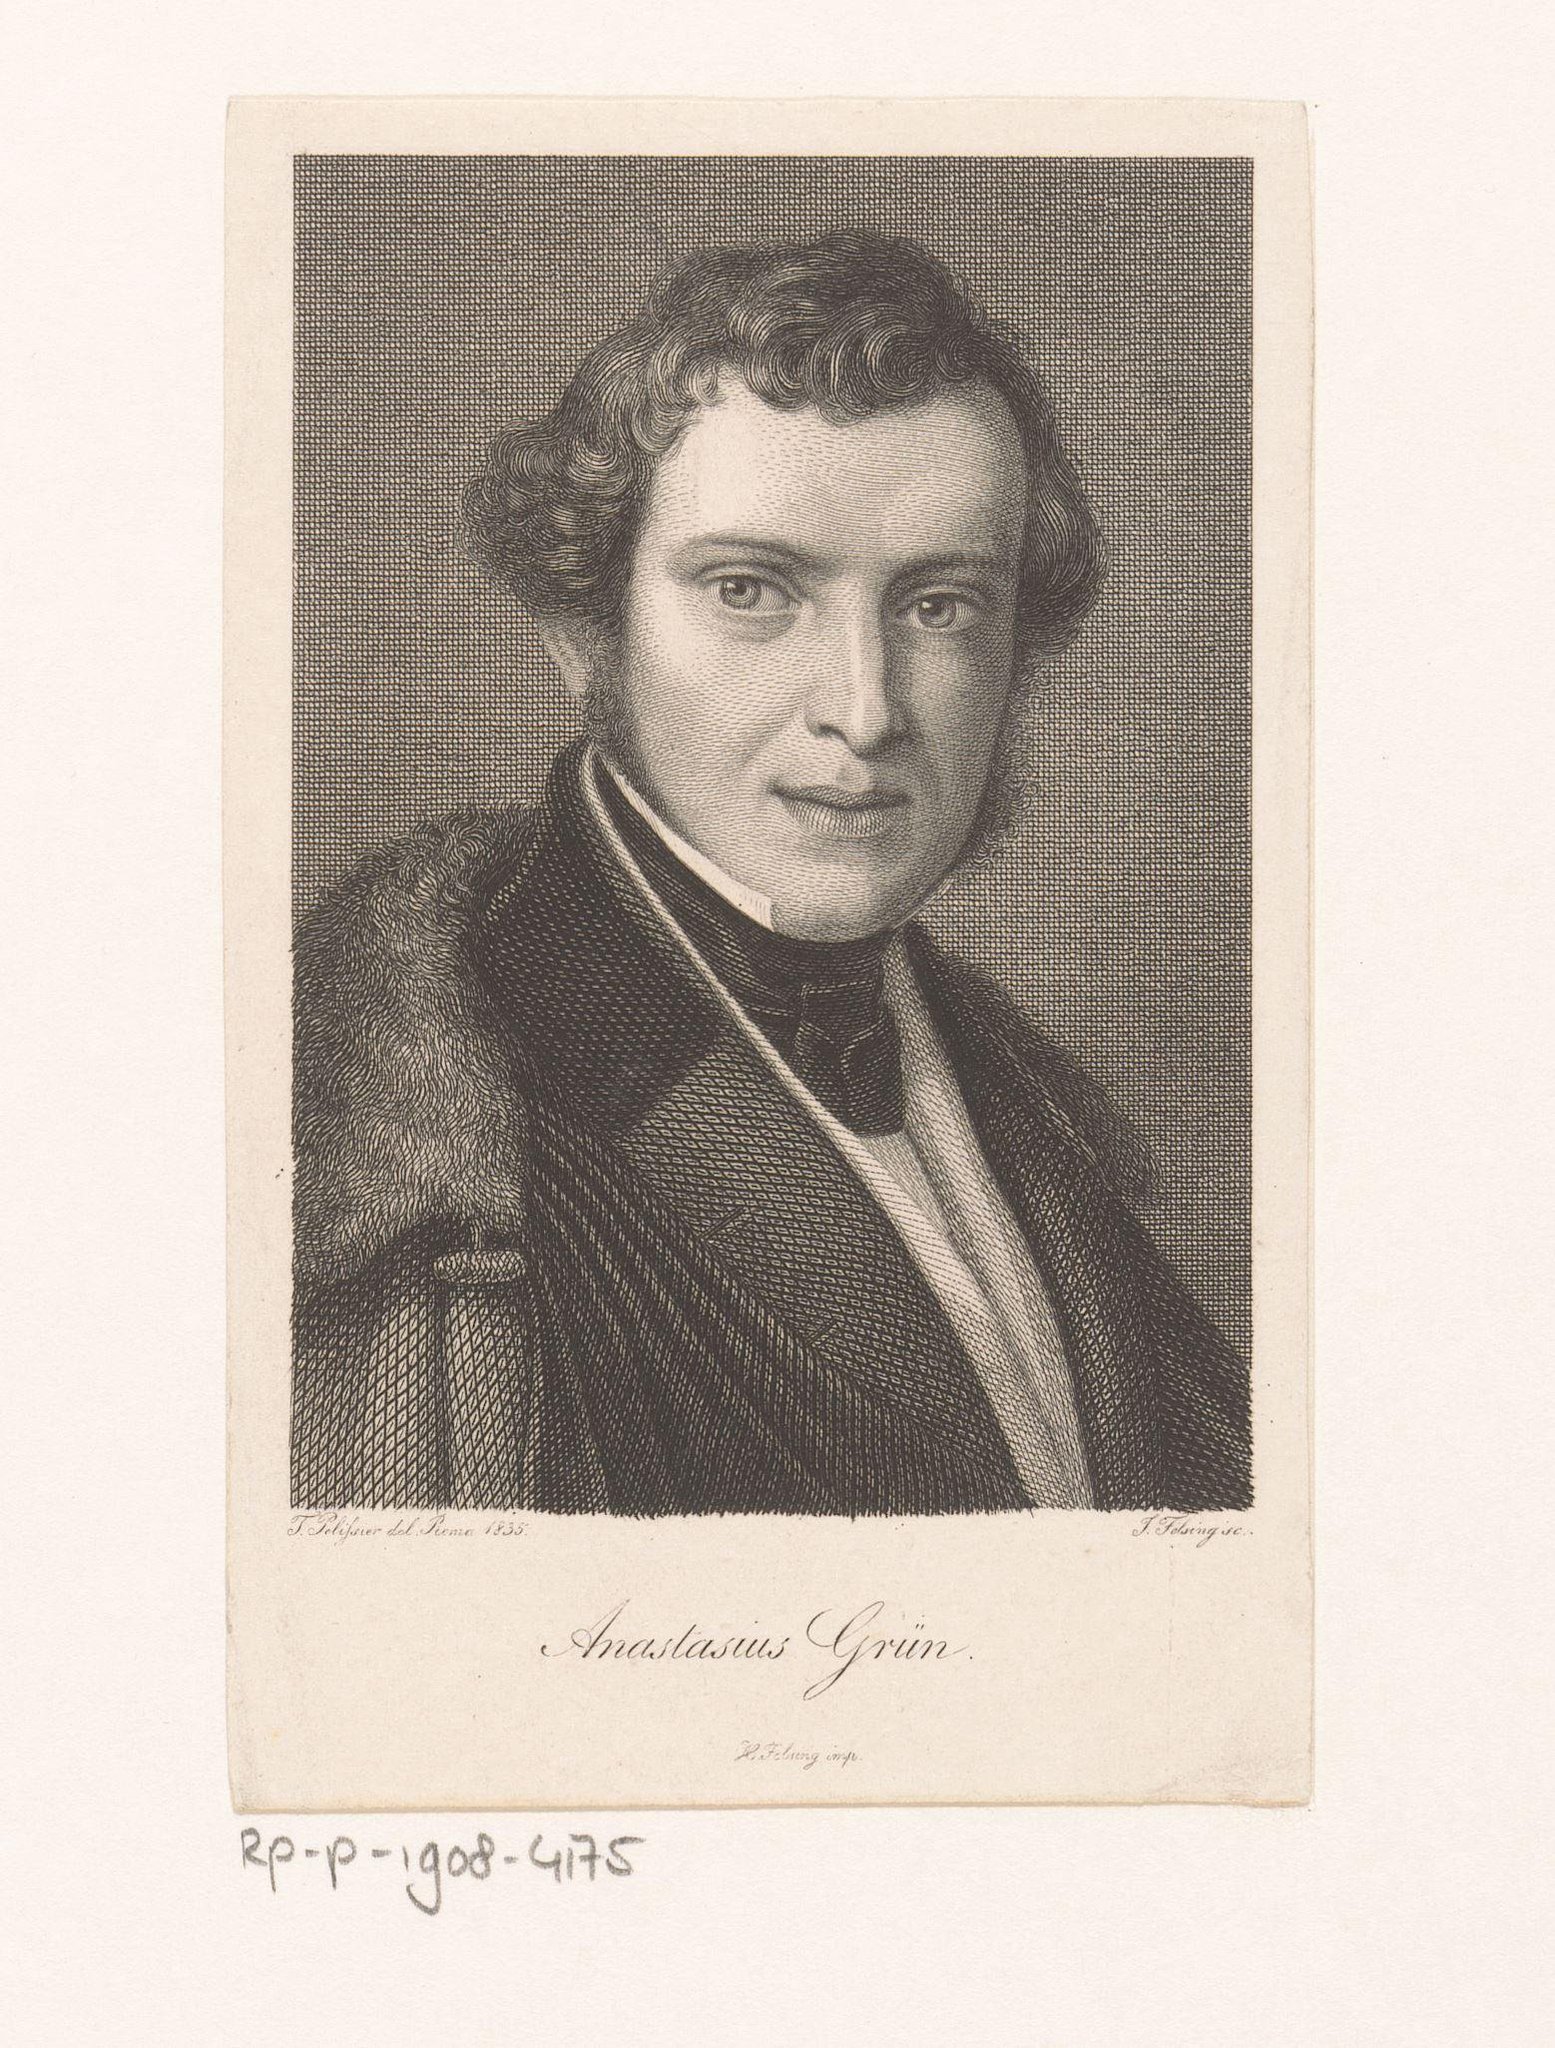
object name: print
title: Portret van Anton von Auersperg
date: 1835-1883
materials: paper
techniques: engraving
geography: rome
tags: historical persons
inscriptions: collector's mark: Lugt 2228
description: Met als onderschrift zijn pseudoniem, Anastasius Grün.